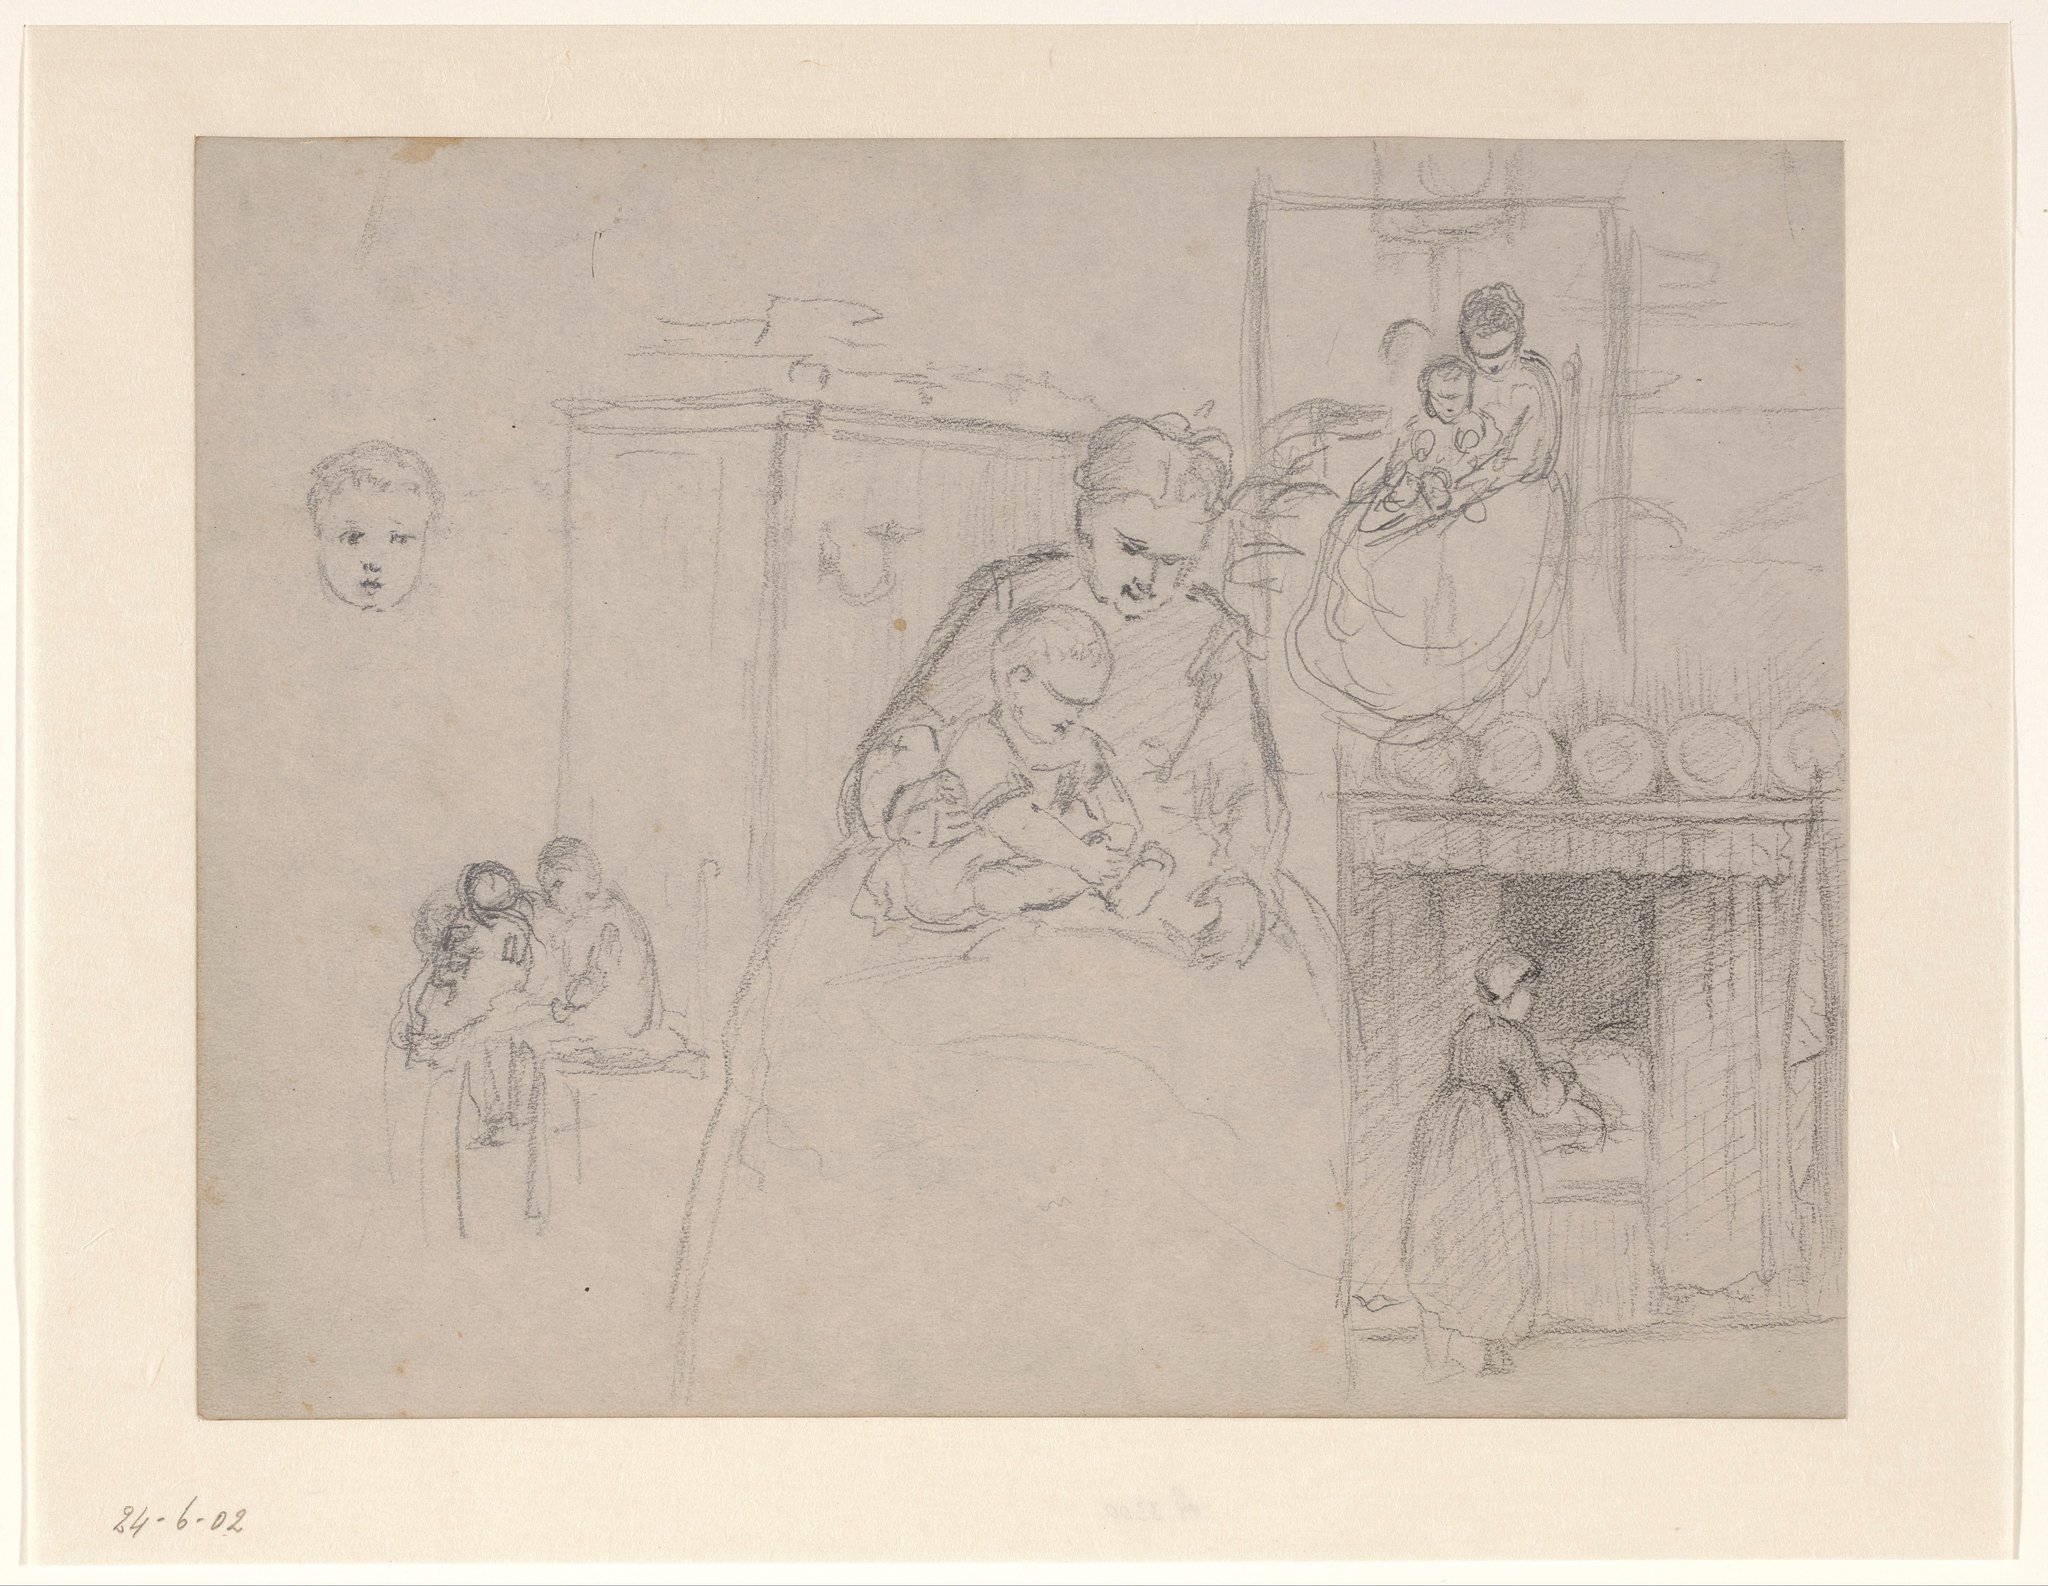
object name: drawing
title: Schetsblad met vrouw met kind en meisje bij bedstede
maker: hendrik valkenburg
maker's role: draughtsman, painter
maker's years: 1826-1896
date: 1836-1896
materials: paper, pencil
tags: interior of the house, mother and child(ren), woman and child(ren) (family group)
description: Schetsblad met vrouw met kind, meisje bij bedstede. Verso: klein kind zittend op de grond.